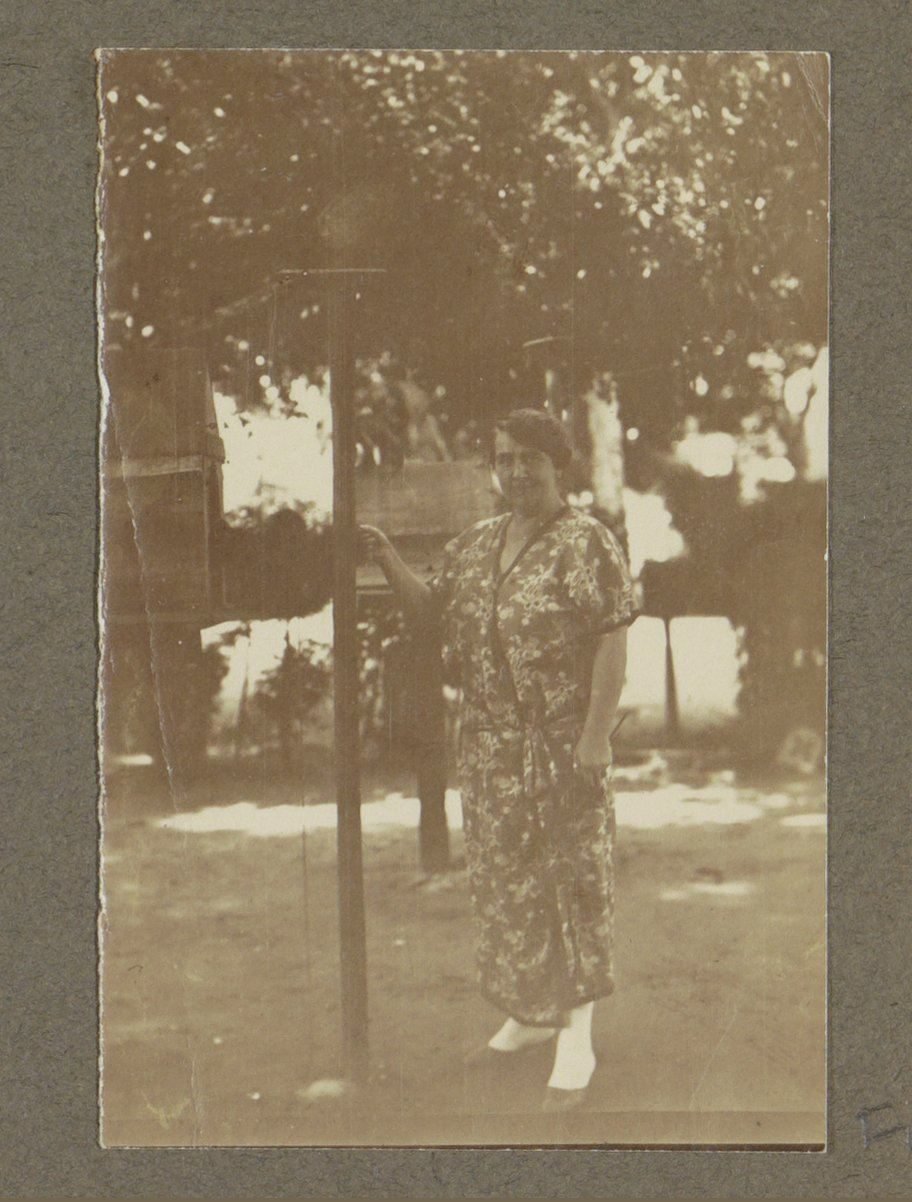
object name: photograph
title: Soeki-baka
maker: Anonymous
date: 1920-1930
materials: photographic support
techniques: daylight paper print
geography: suriname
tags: adult woman, suriname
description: Onderdeel van fotoalbum van een onbekende Nederlandse familie met opnames van Suriname, Europa en Nederlands-Indië.